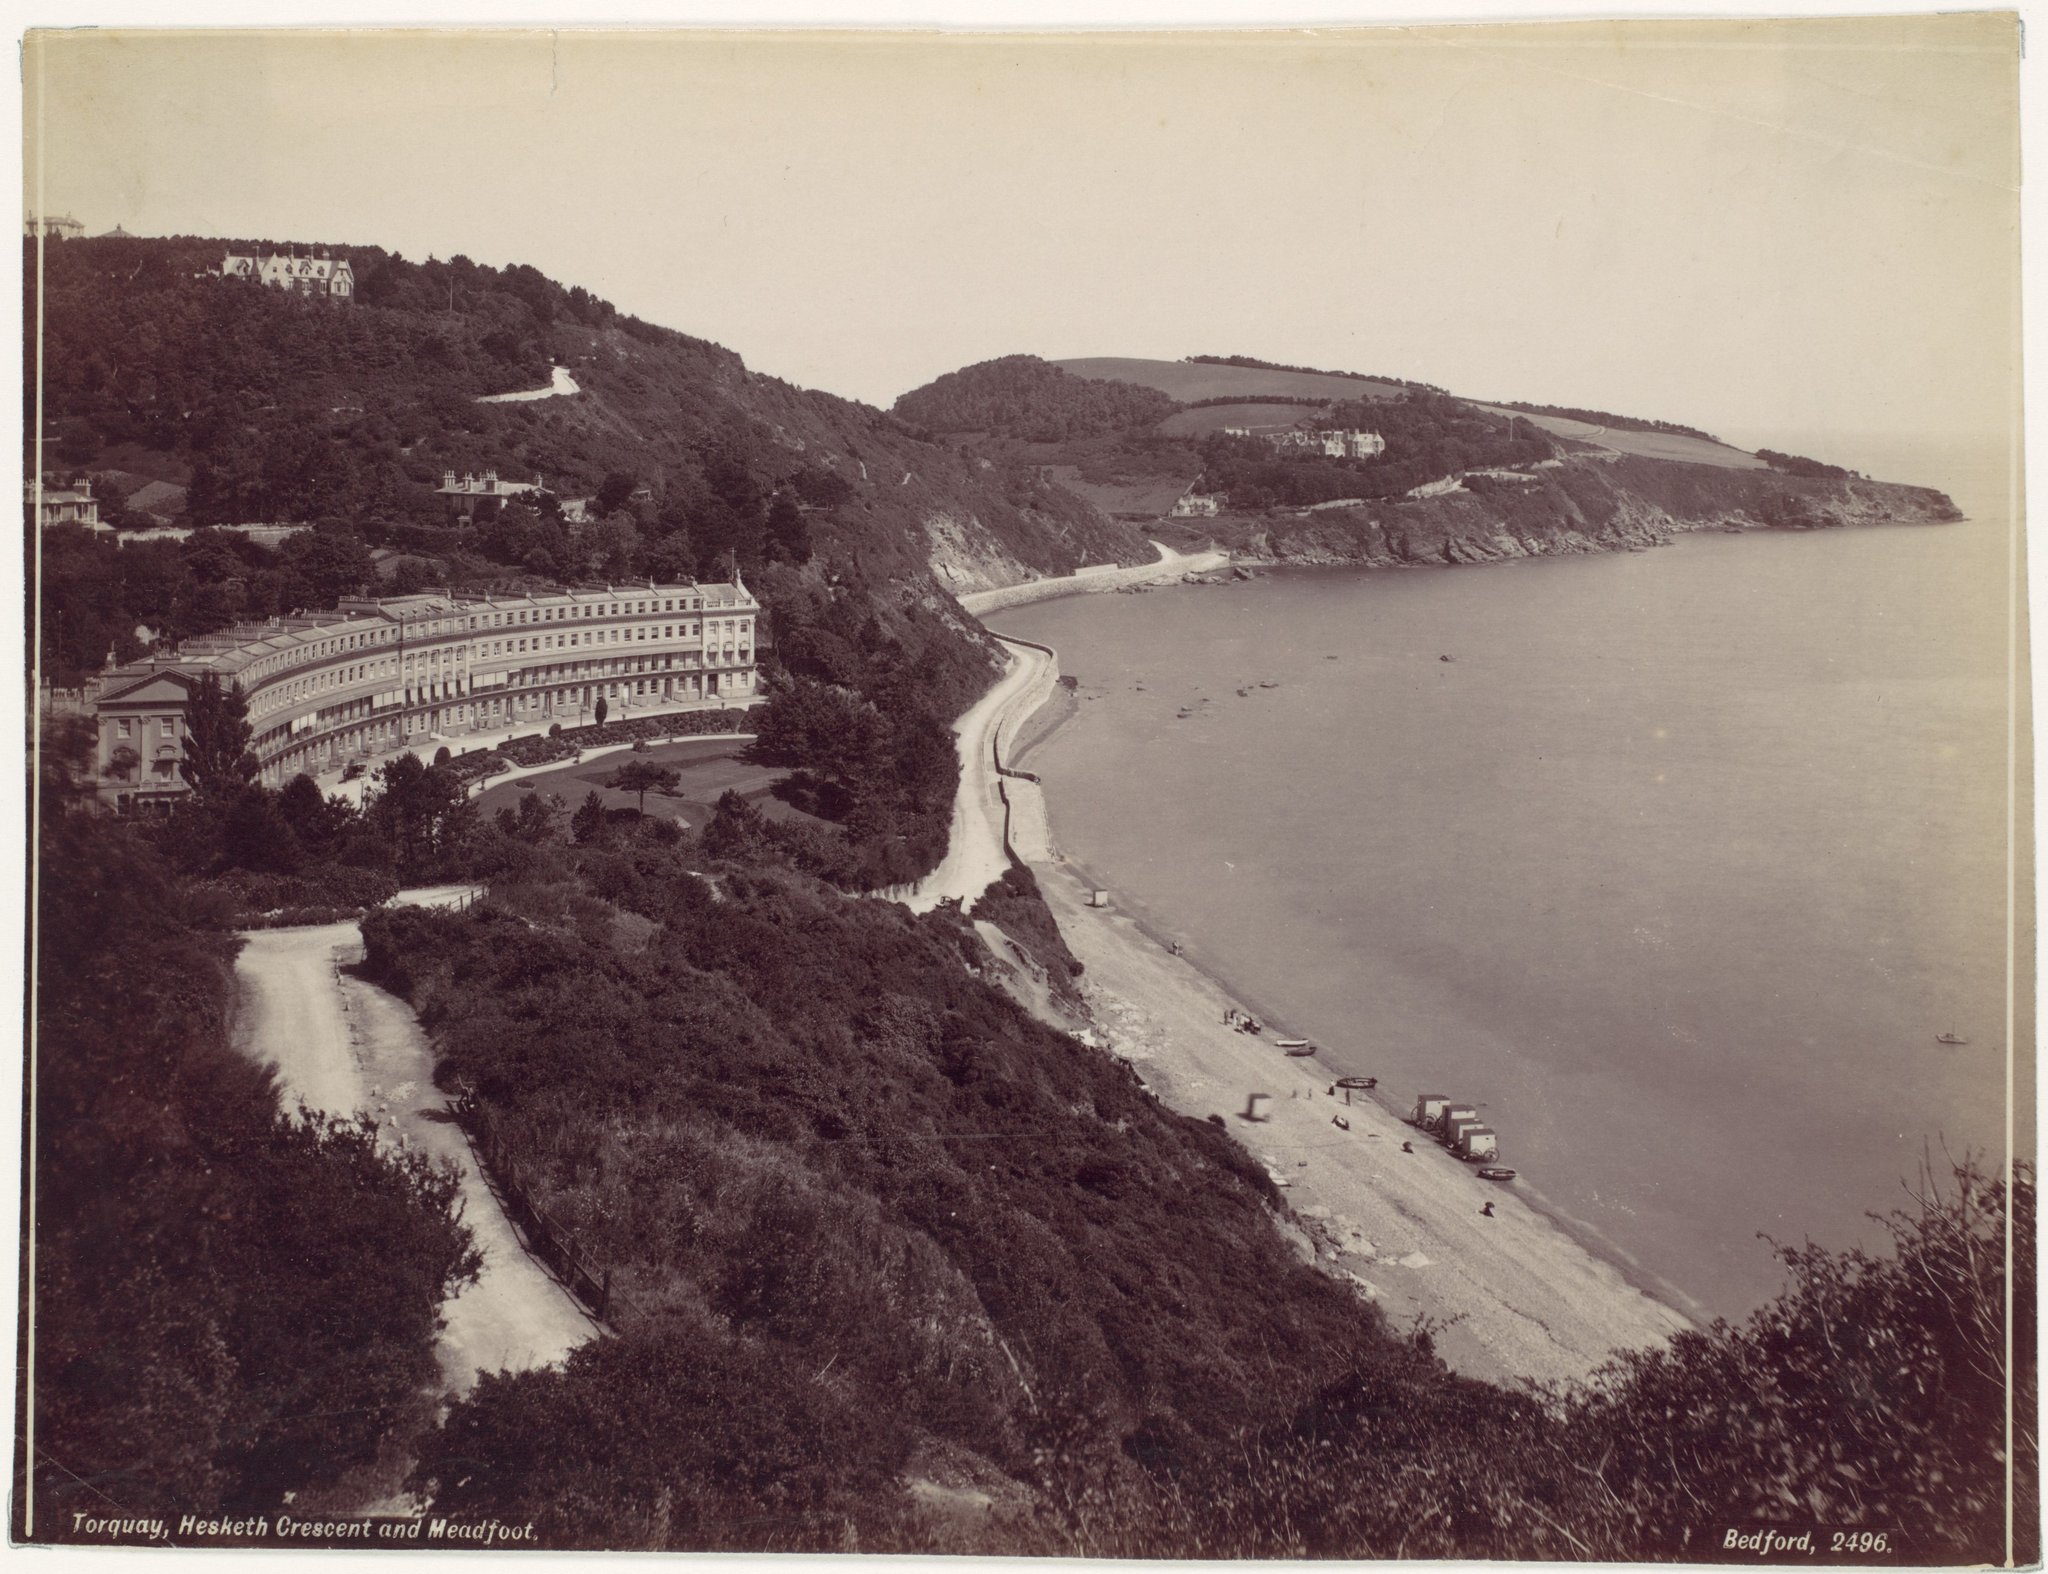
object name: photograph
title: Torquay, Hesketh Crescent and Meadfoot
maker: francis bedford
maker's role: artist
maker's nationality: british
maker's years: 1816-1894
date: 1870-1879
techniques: albumen silver print, glass negative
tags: towns,landscapes